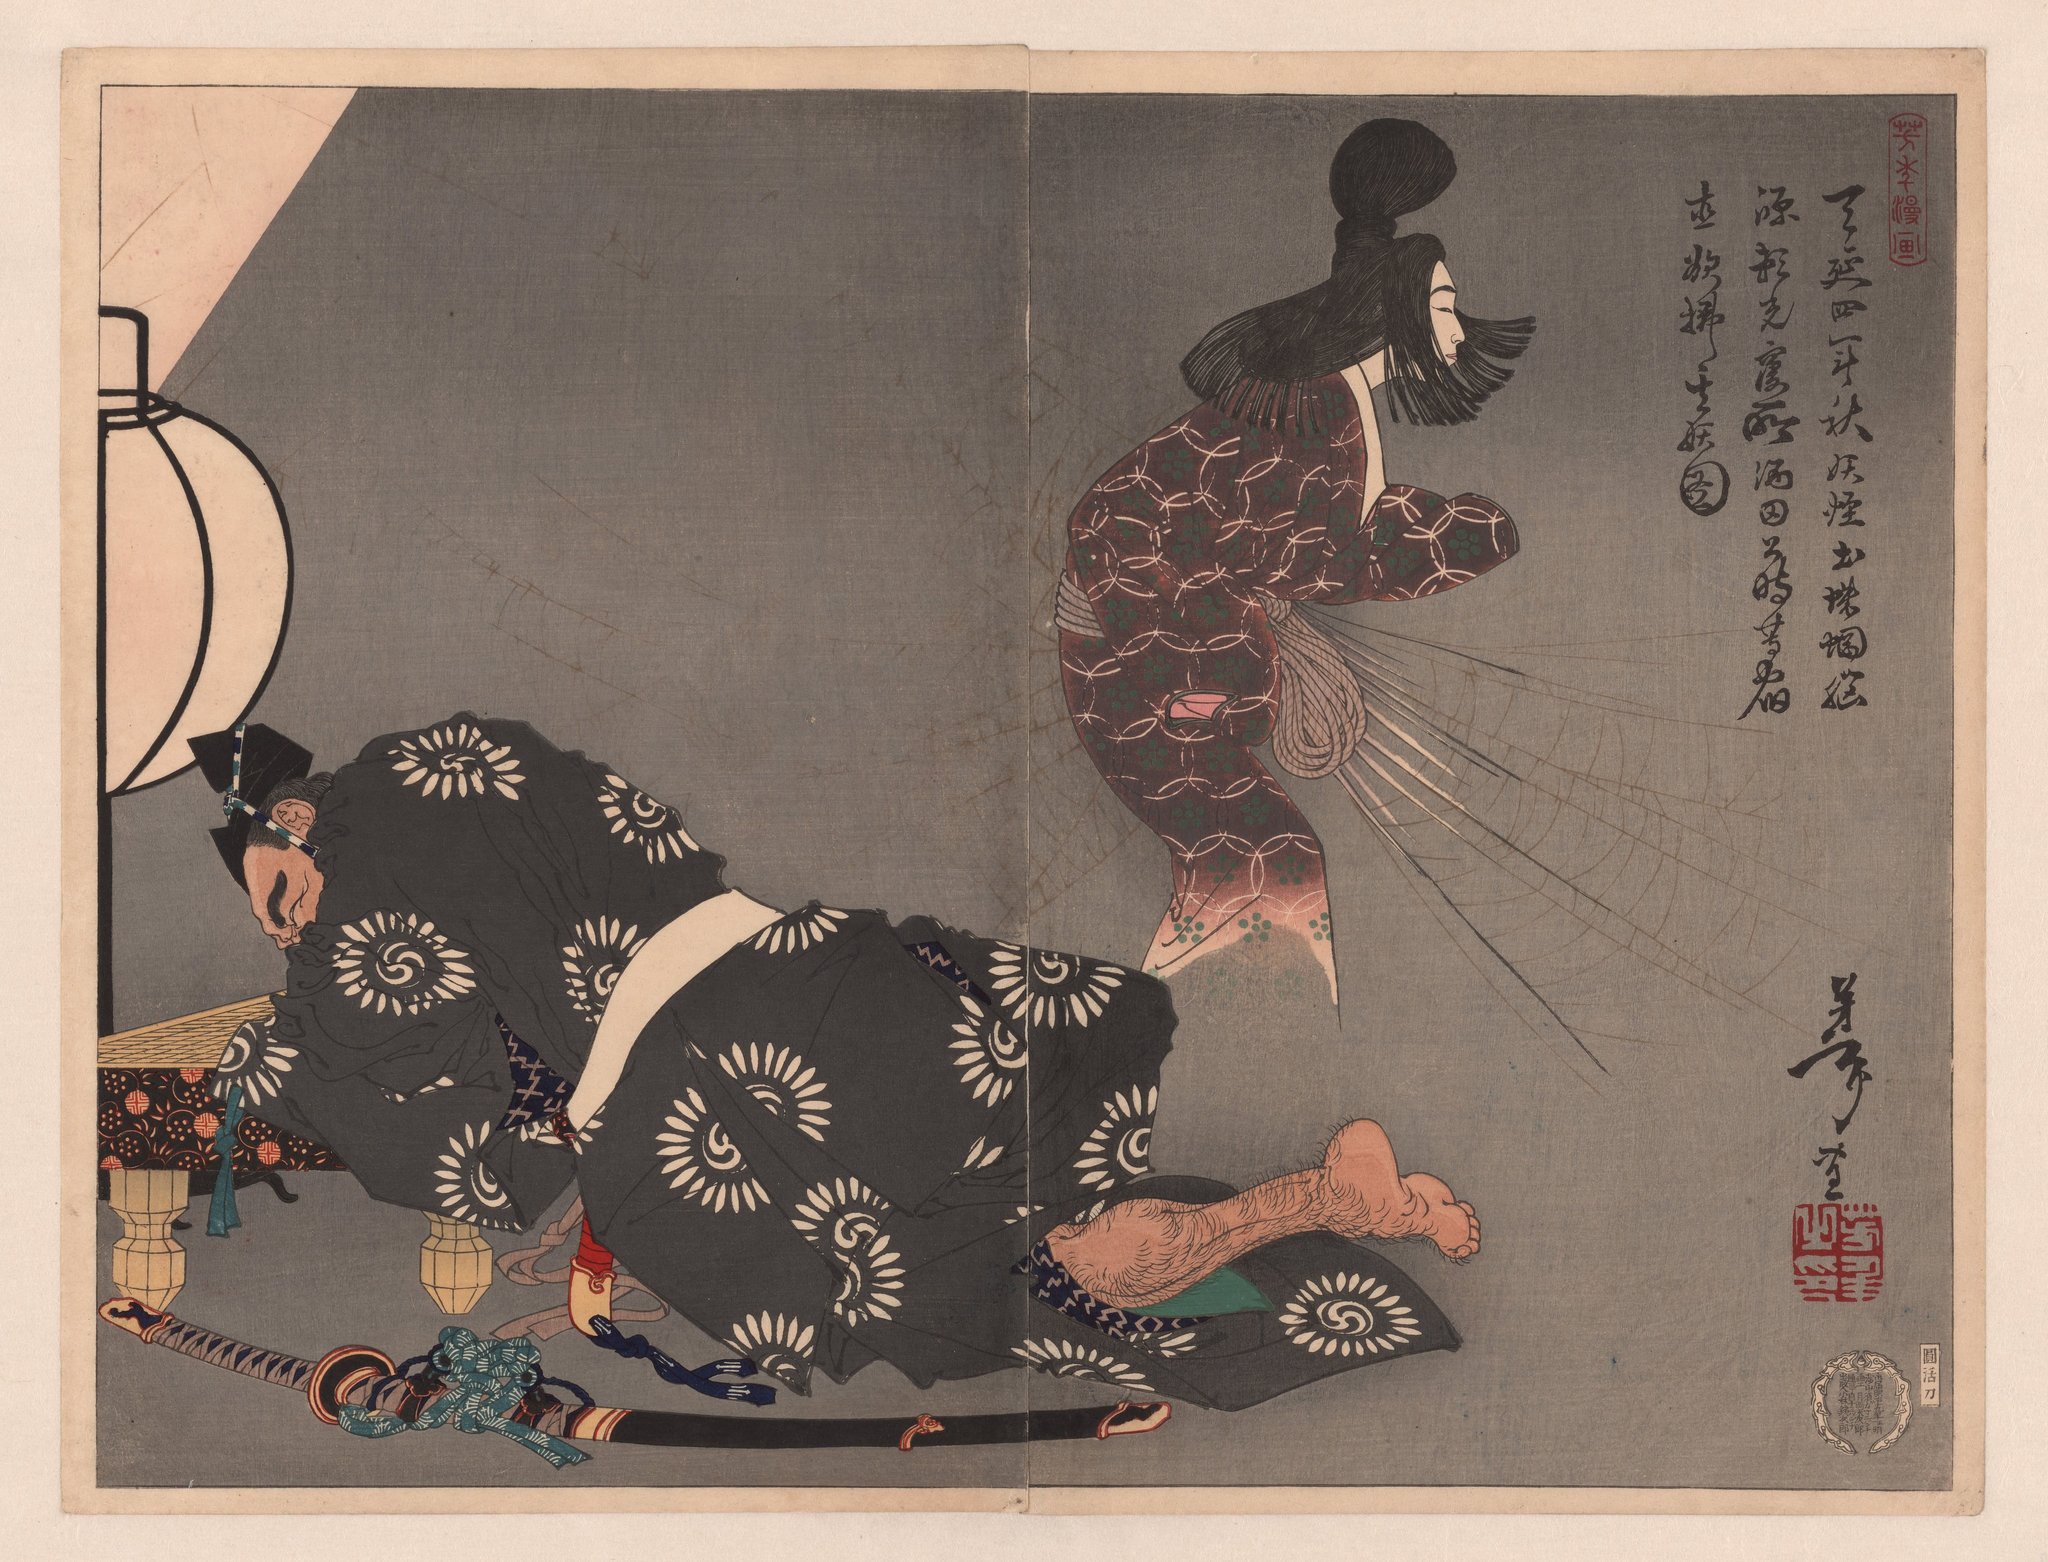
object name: print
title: Schetsen van Yoshitoshi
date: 1886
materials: paper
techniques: woodcut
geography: tokyo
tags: lying face downwards, monsters of mixed human and animal shape; 'mostri' (ripa)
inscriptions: date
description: Sakata Kintoki liggend over een tafel nabij een lantaarn, zijn zwaard naast hem. Achter hem Tsuchigumo, een spinachtig monster, hier in de gedaante van een vrouw, tussen spinnenwebben.